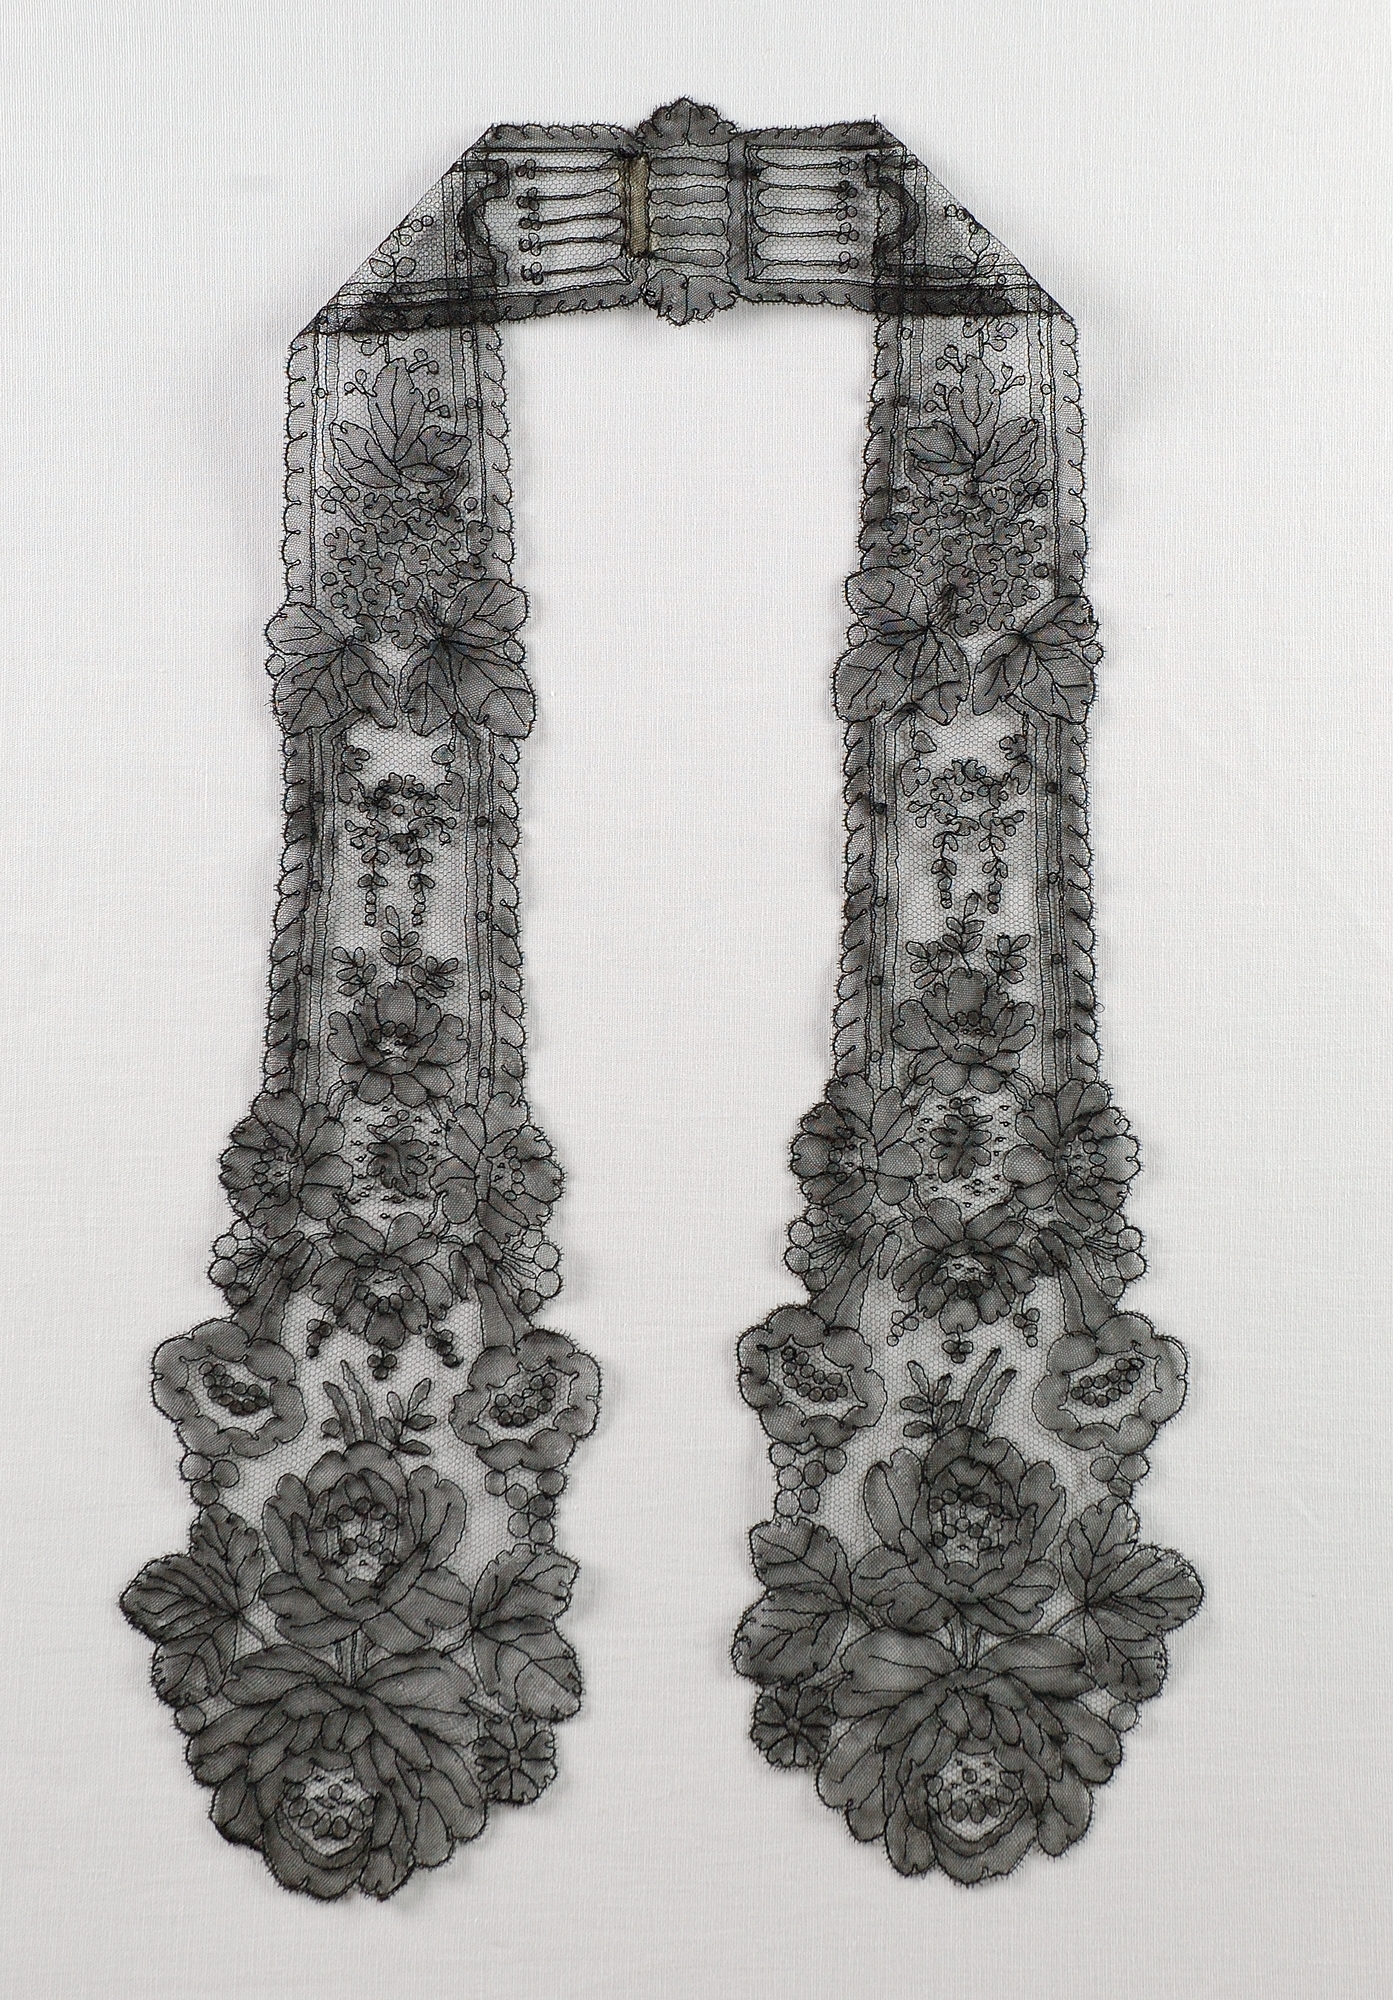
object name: lappet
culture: french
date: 1877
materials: silk